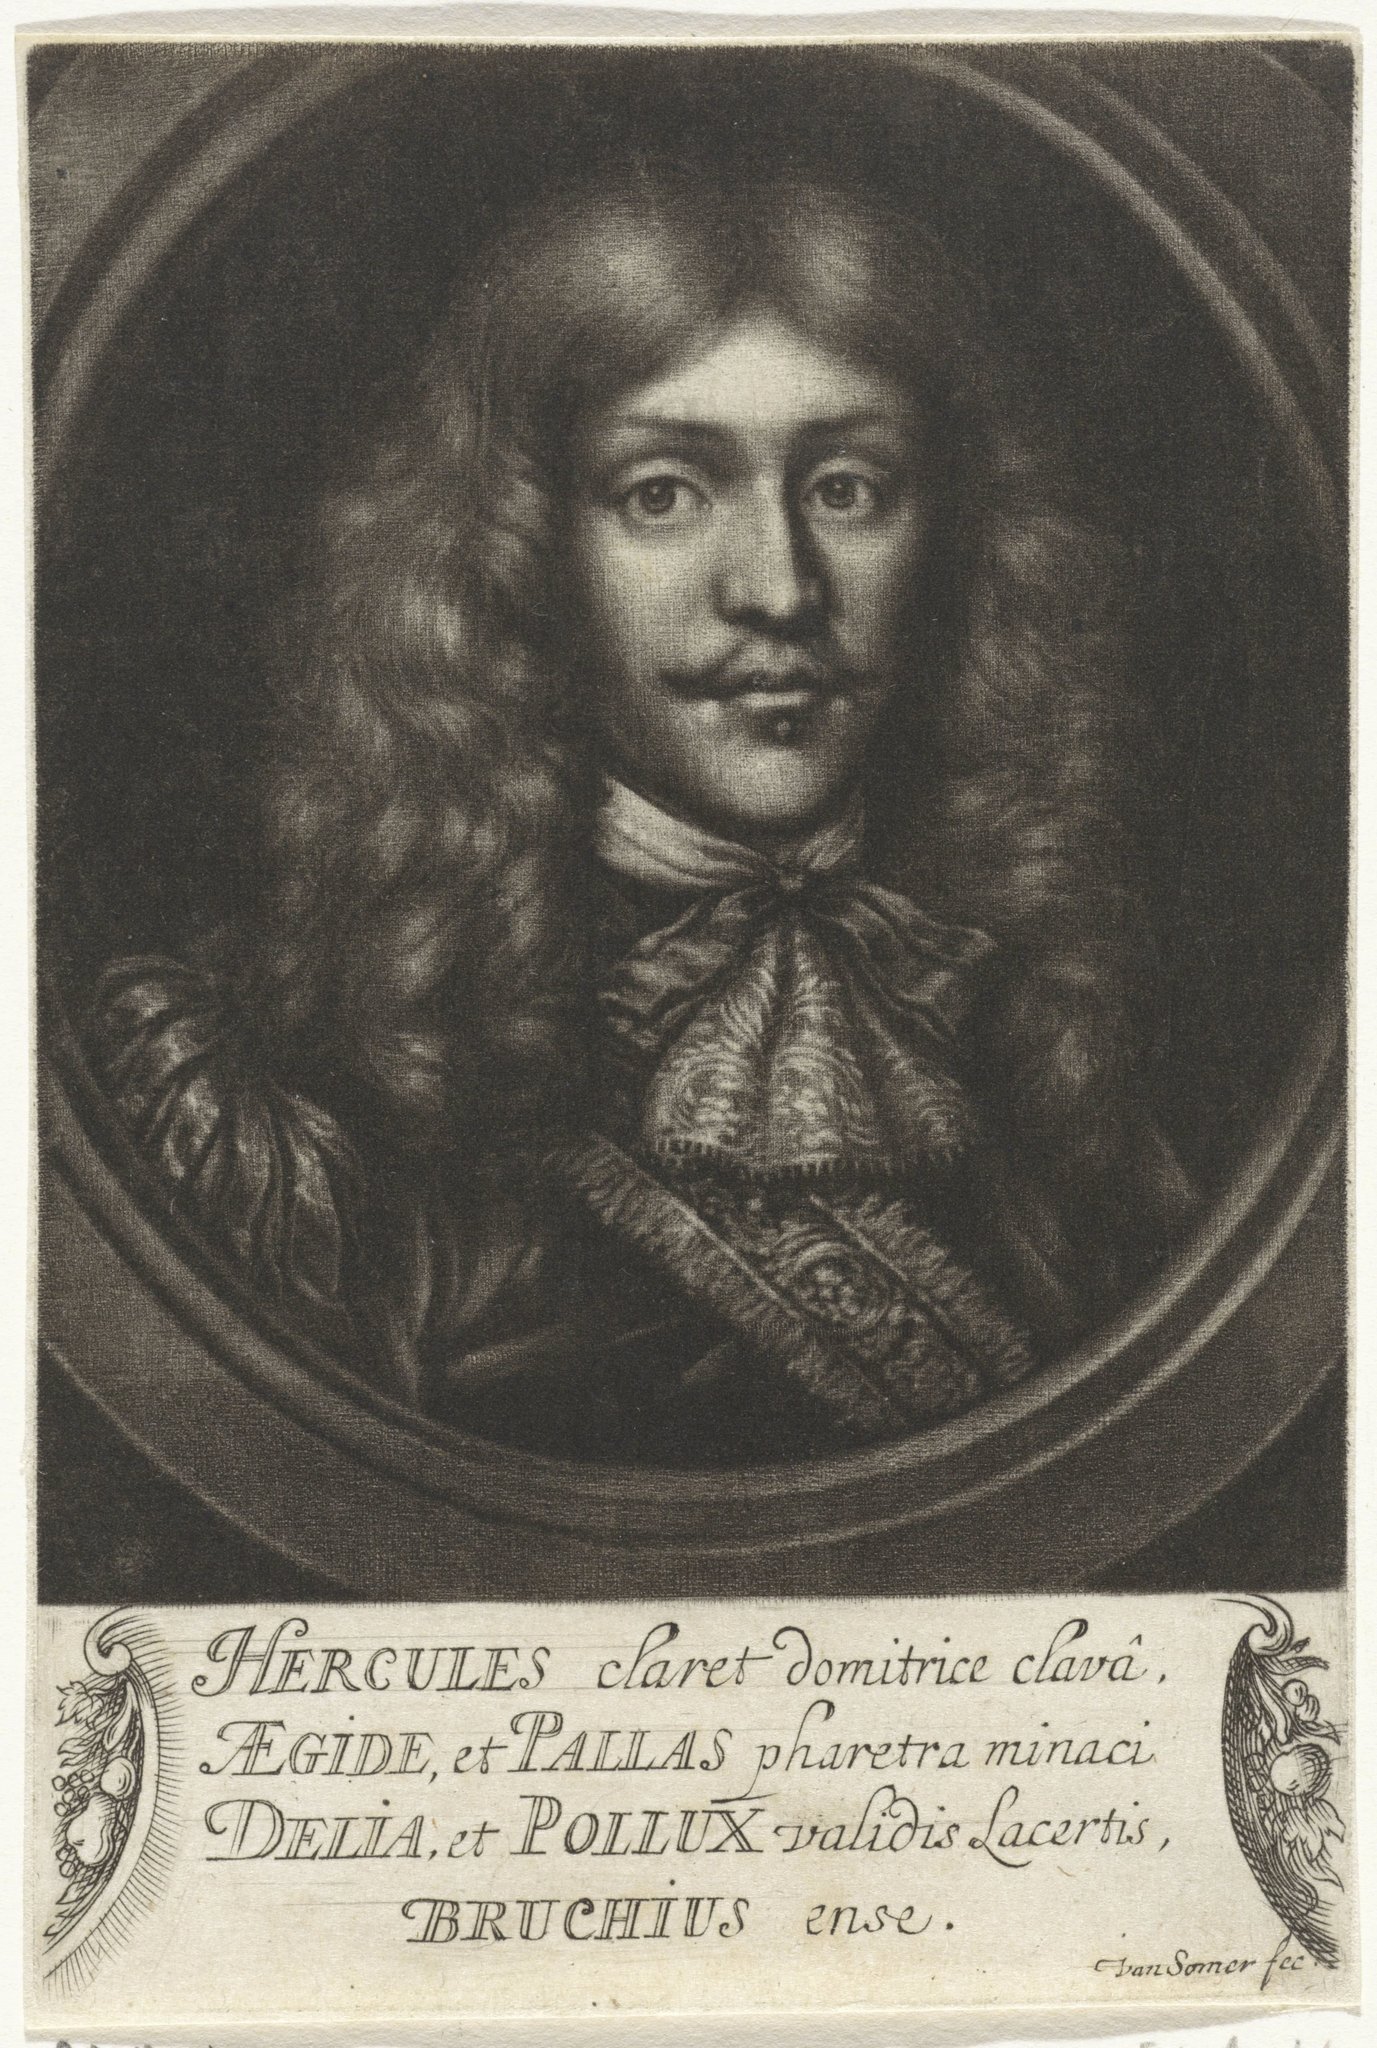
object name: print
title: Portret van Johann Georg Bruck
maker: jan van somer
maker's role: draughtsman, print maker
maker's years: 1645-1699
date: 1655-1700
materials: paper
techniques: engraving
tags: moustache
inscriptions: collector's mark: Lugt 2228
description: De schermmeester Johann Georg Bruck, met een snor en lang krullend haar. Hij draagt een das van kant en heeft een bandelier over de rechterschouder.